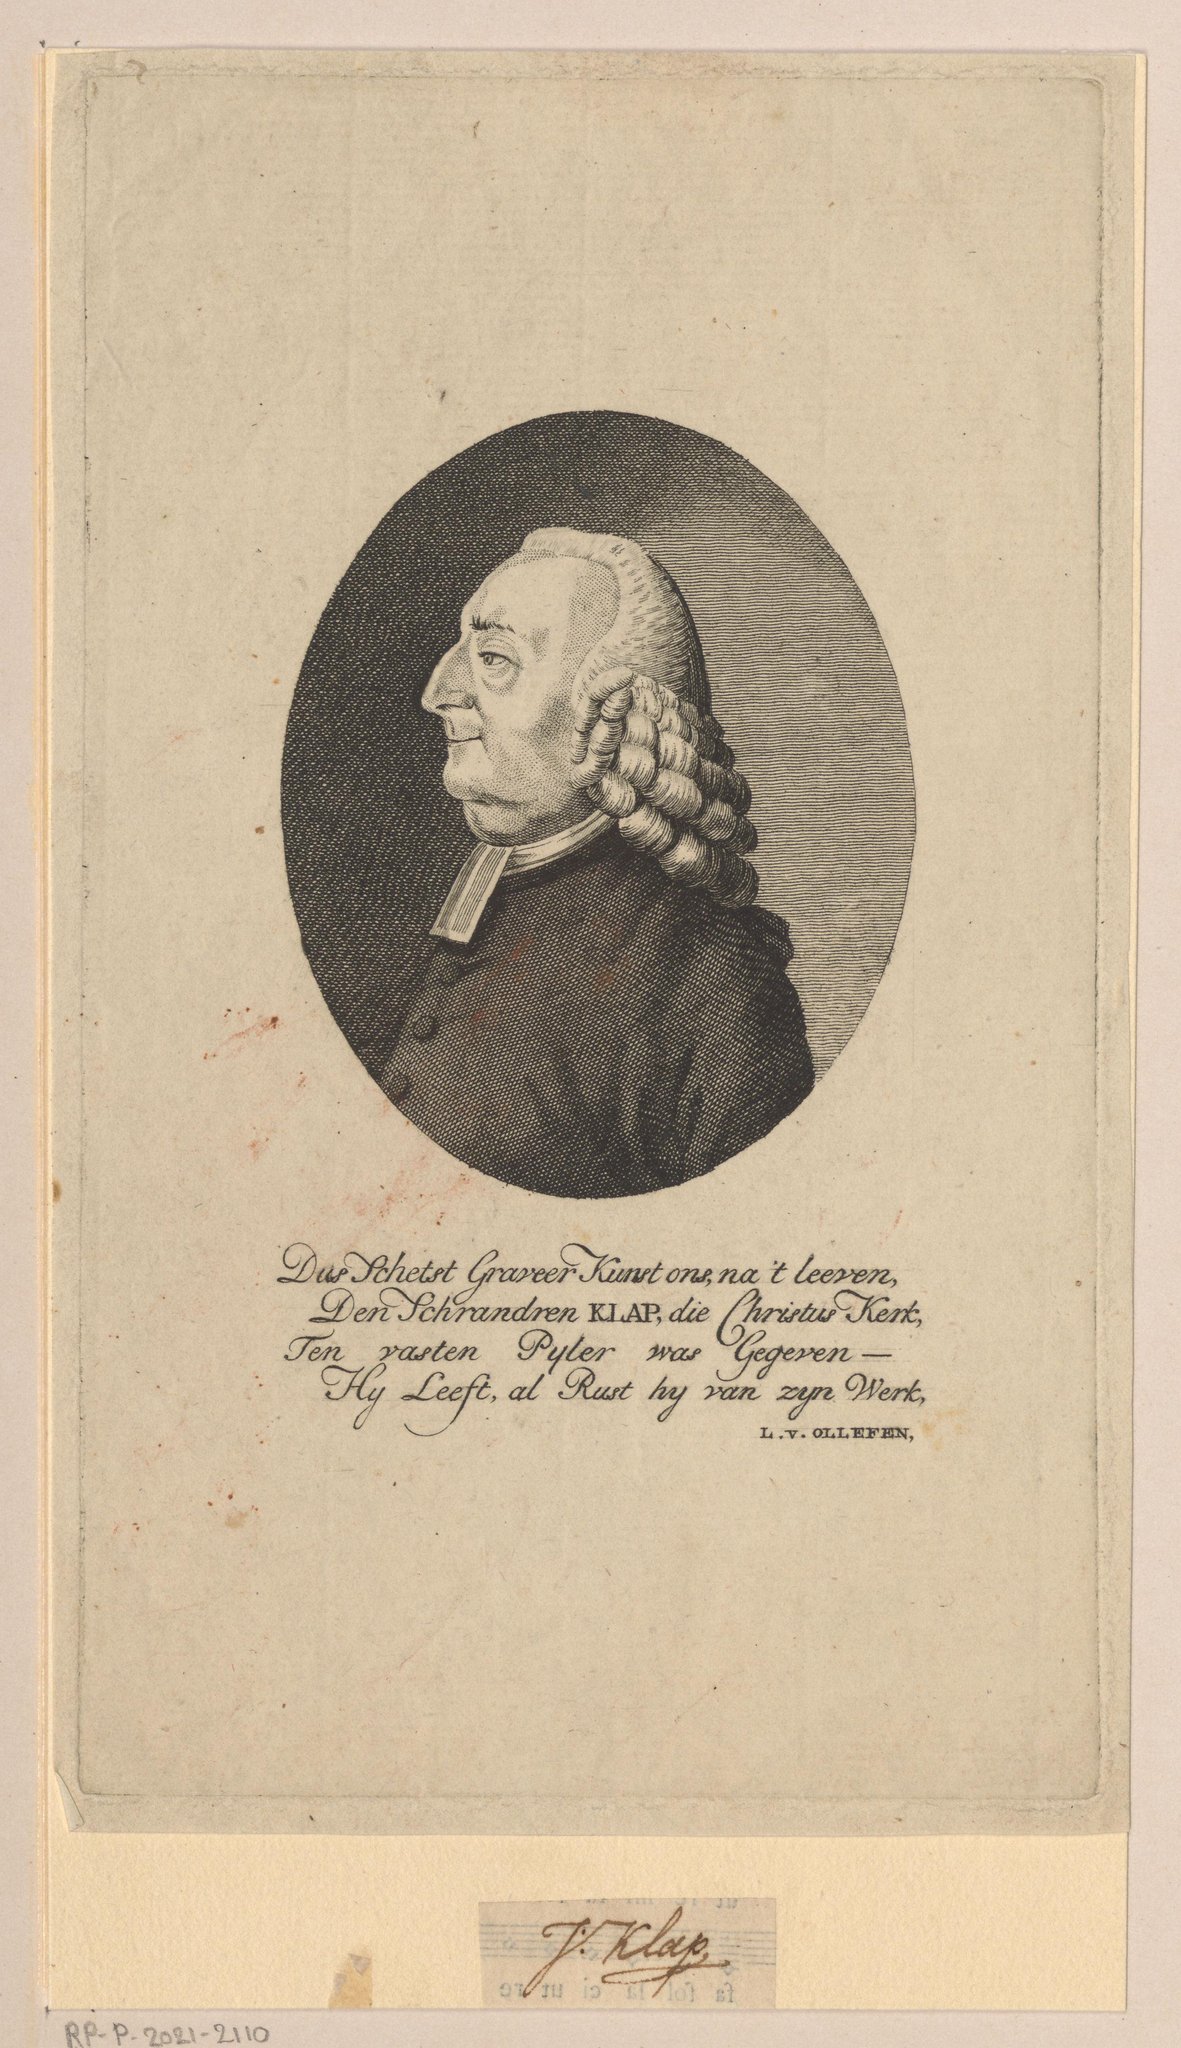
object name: print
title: Portret van Johannes Klap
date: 1799-1816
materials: paper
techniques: engraving, etching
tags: amsterdam, historical persons